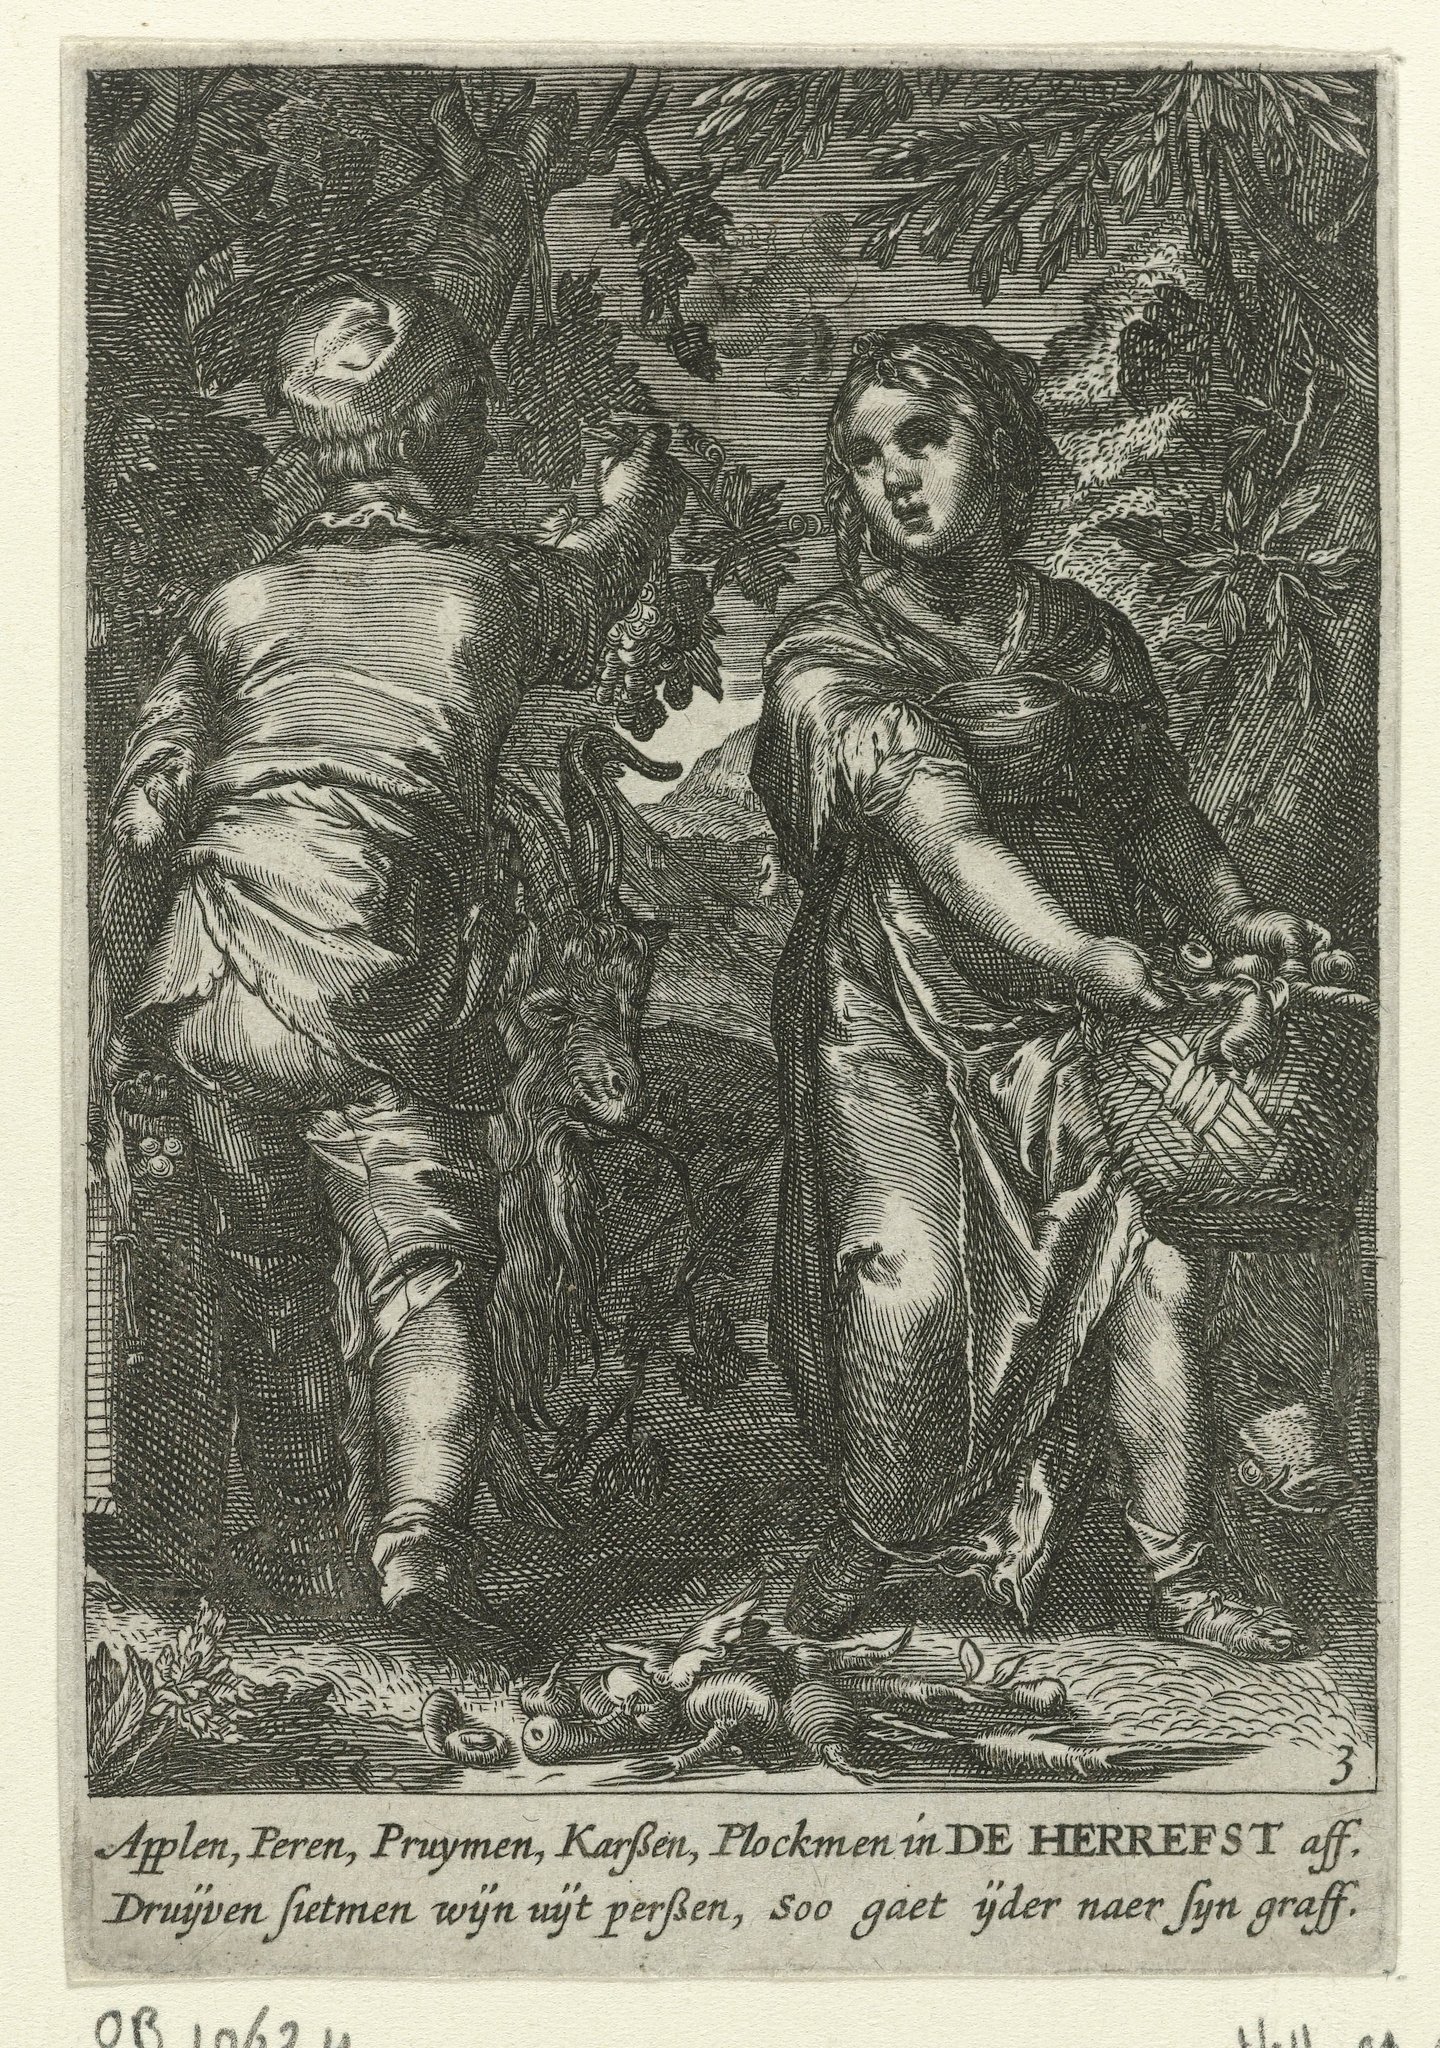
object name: print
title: De vier seizoenen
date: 1601-1651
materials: paper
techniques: engraving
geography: amsterdam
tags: fruit-tree culture; fruit harvest, boar (male pig), he-goat, billy-goat, vintage, grape harvest, autumn, fall, 'autumnus'; 'autunno' (ripa)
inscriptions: collector's mark: Lugt 2228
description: Een jongen en een meisje oogsten fruit in het bijzijn van een bok en een zwijn. De jongen plukt druiven, het meisje draagt een mand met peren.